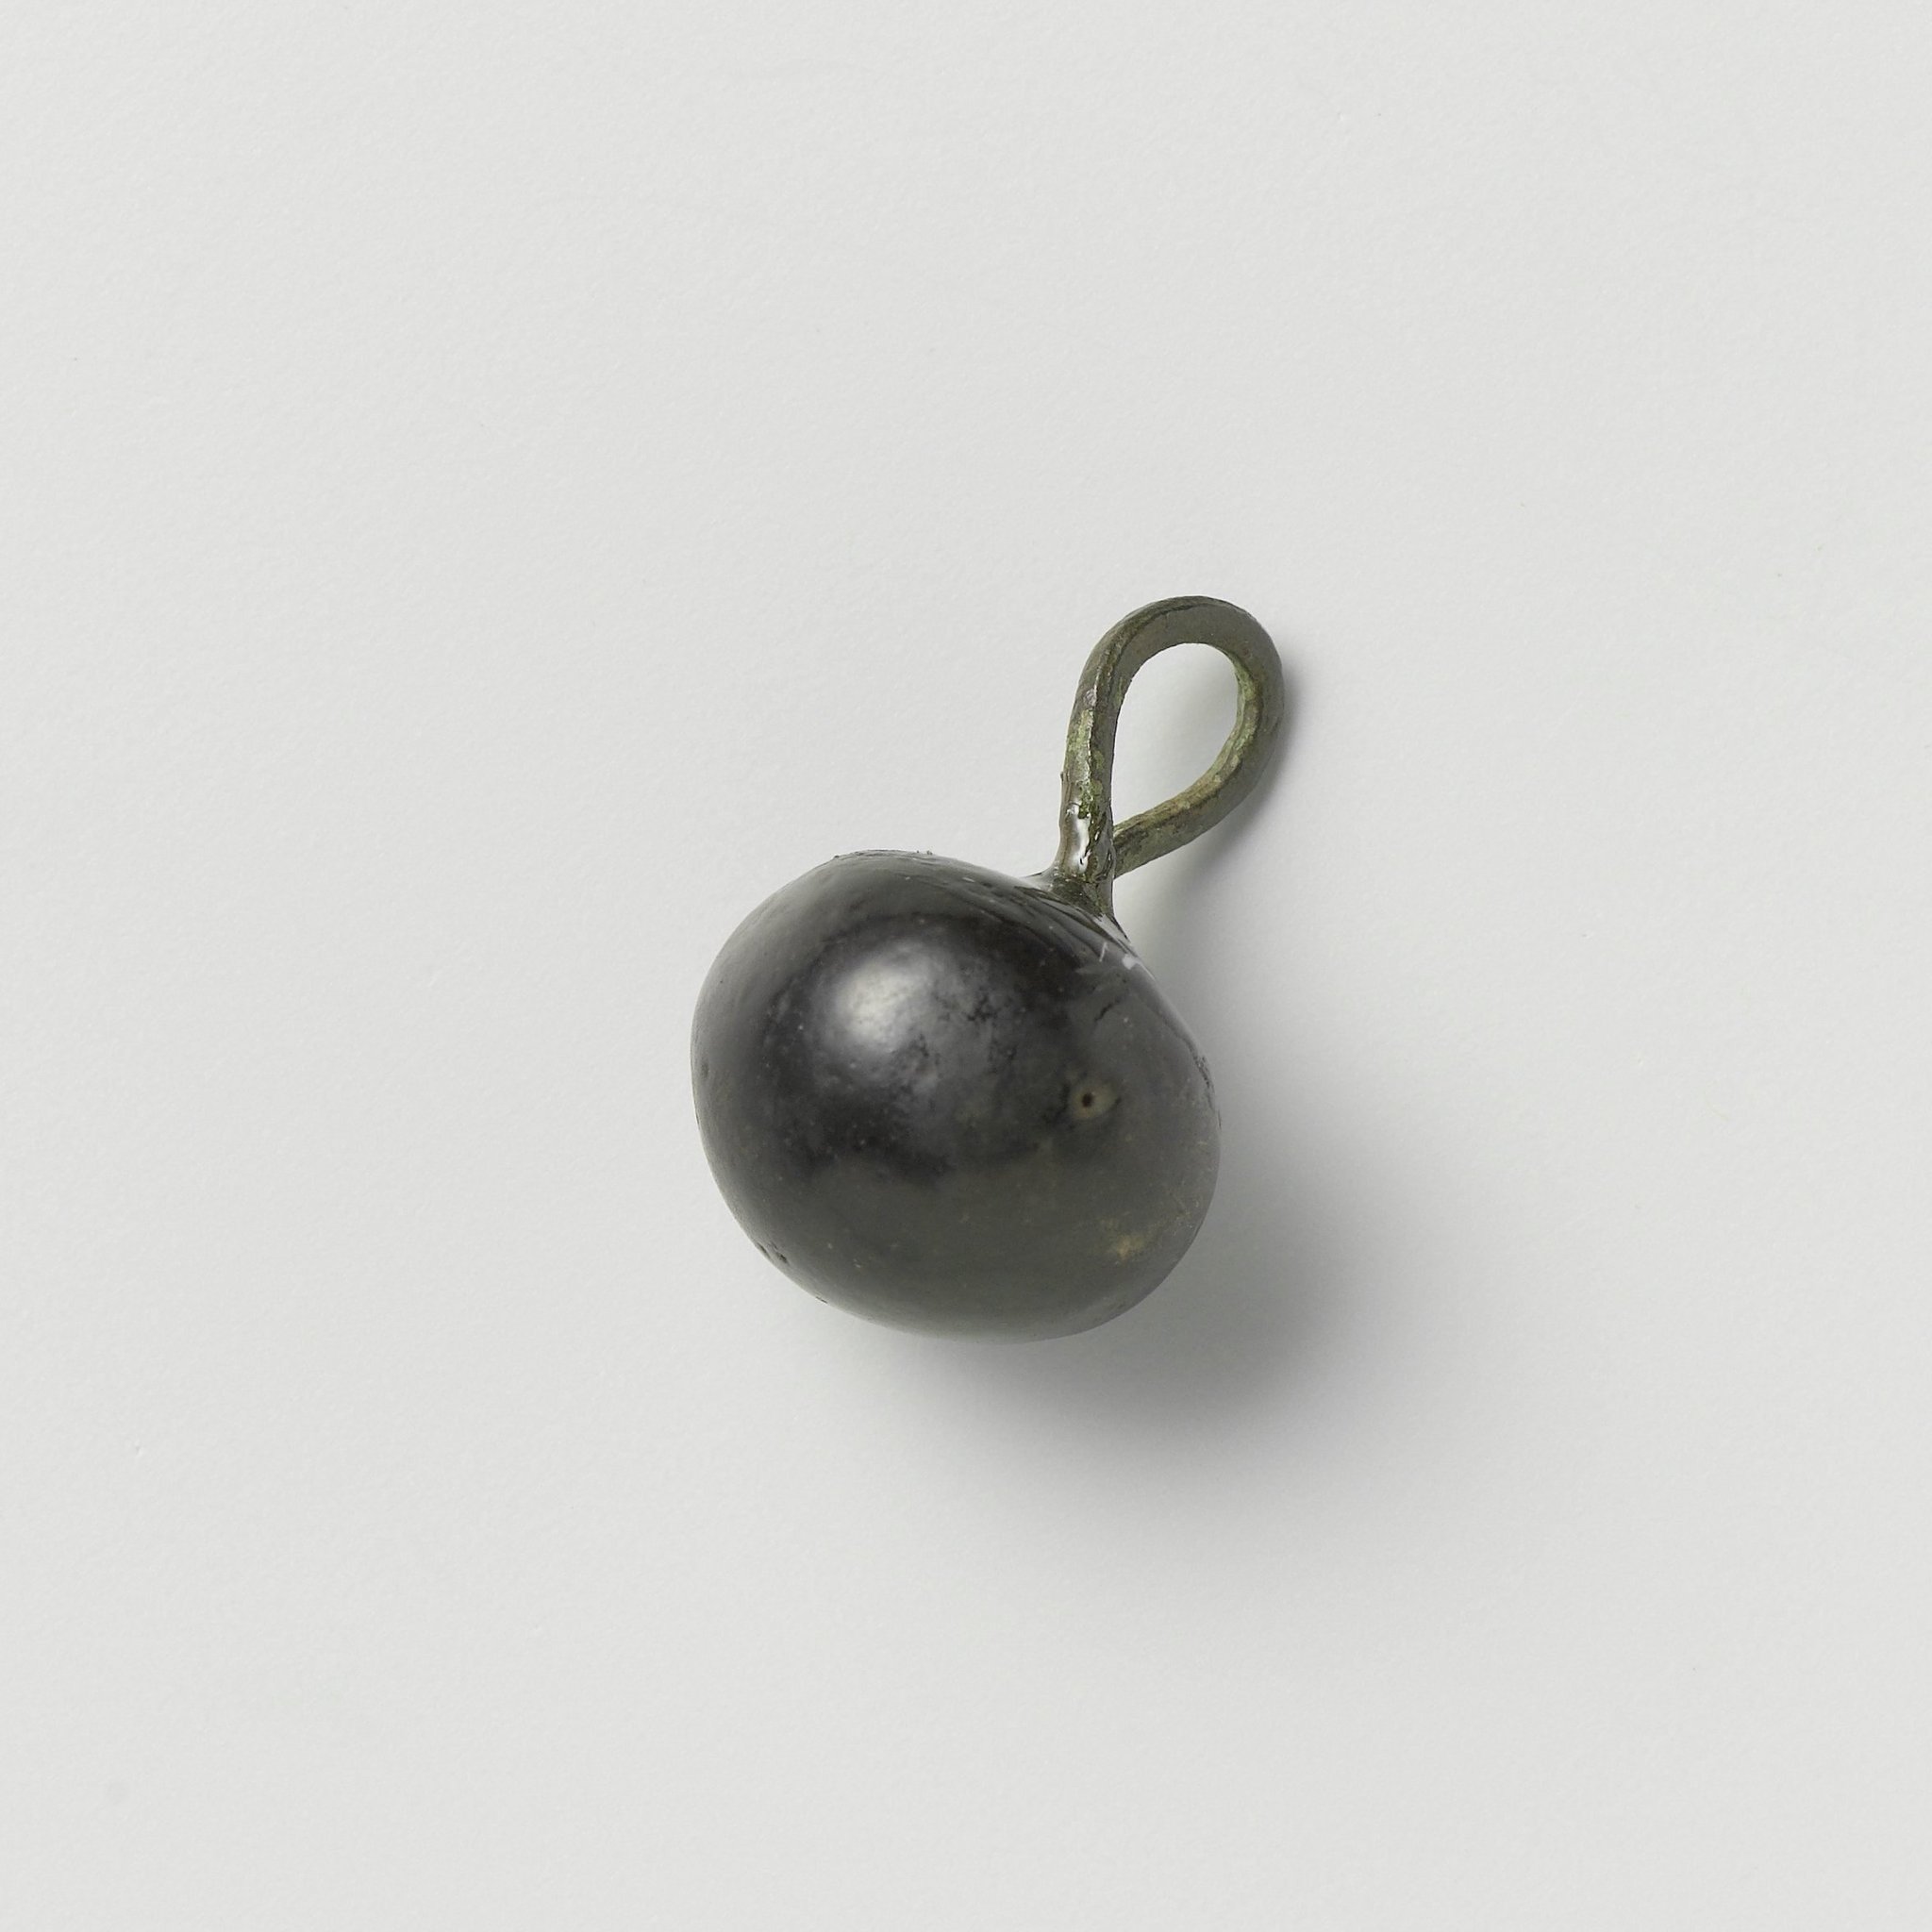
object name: button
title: Knoop van zwart glas of git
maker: Anonymous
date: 1590-1596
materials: glass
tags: willem barendsz., amsterdam, jacob van heemskerck